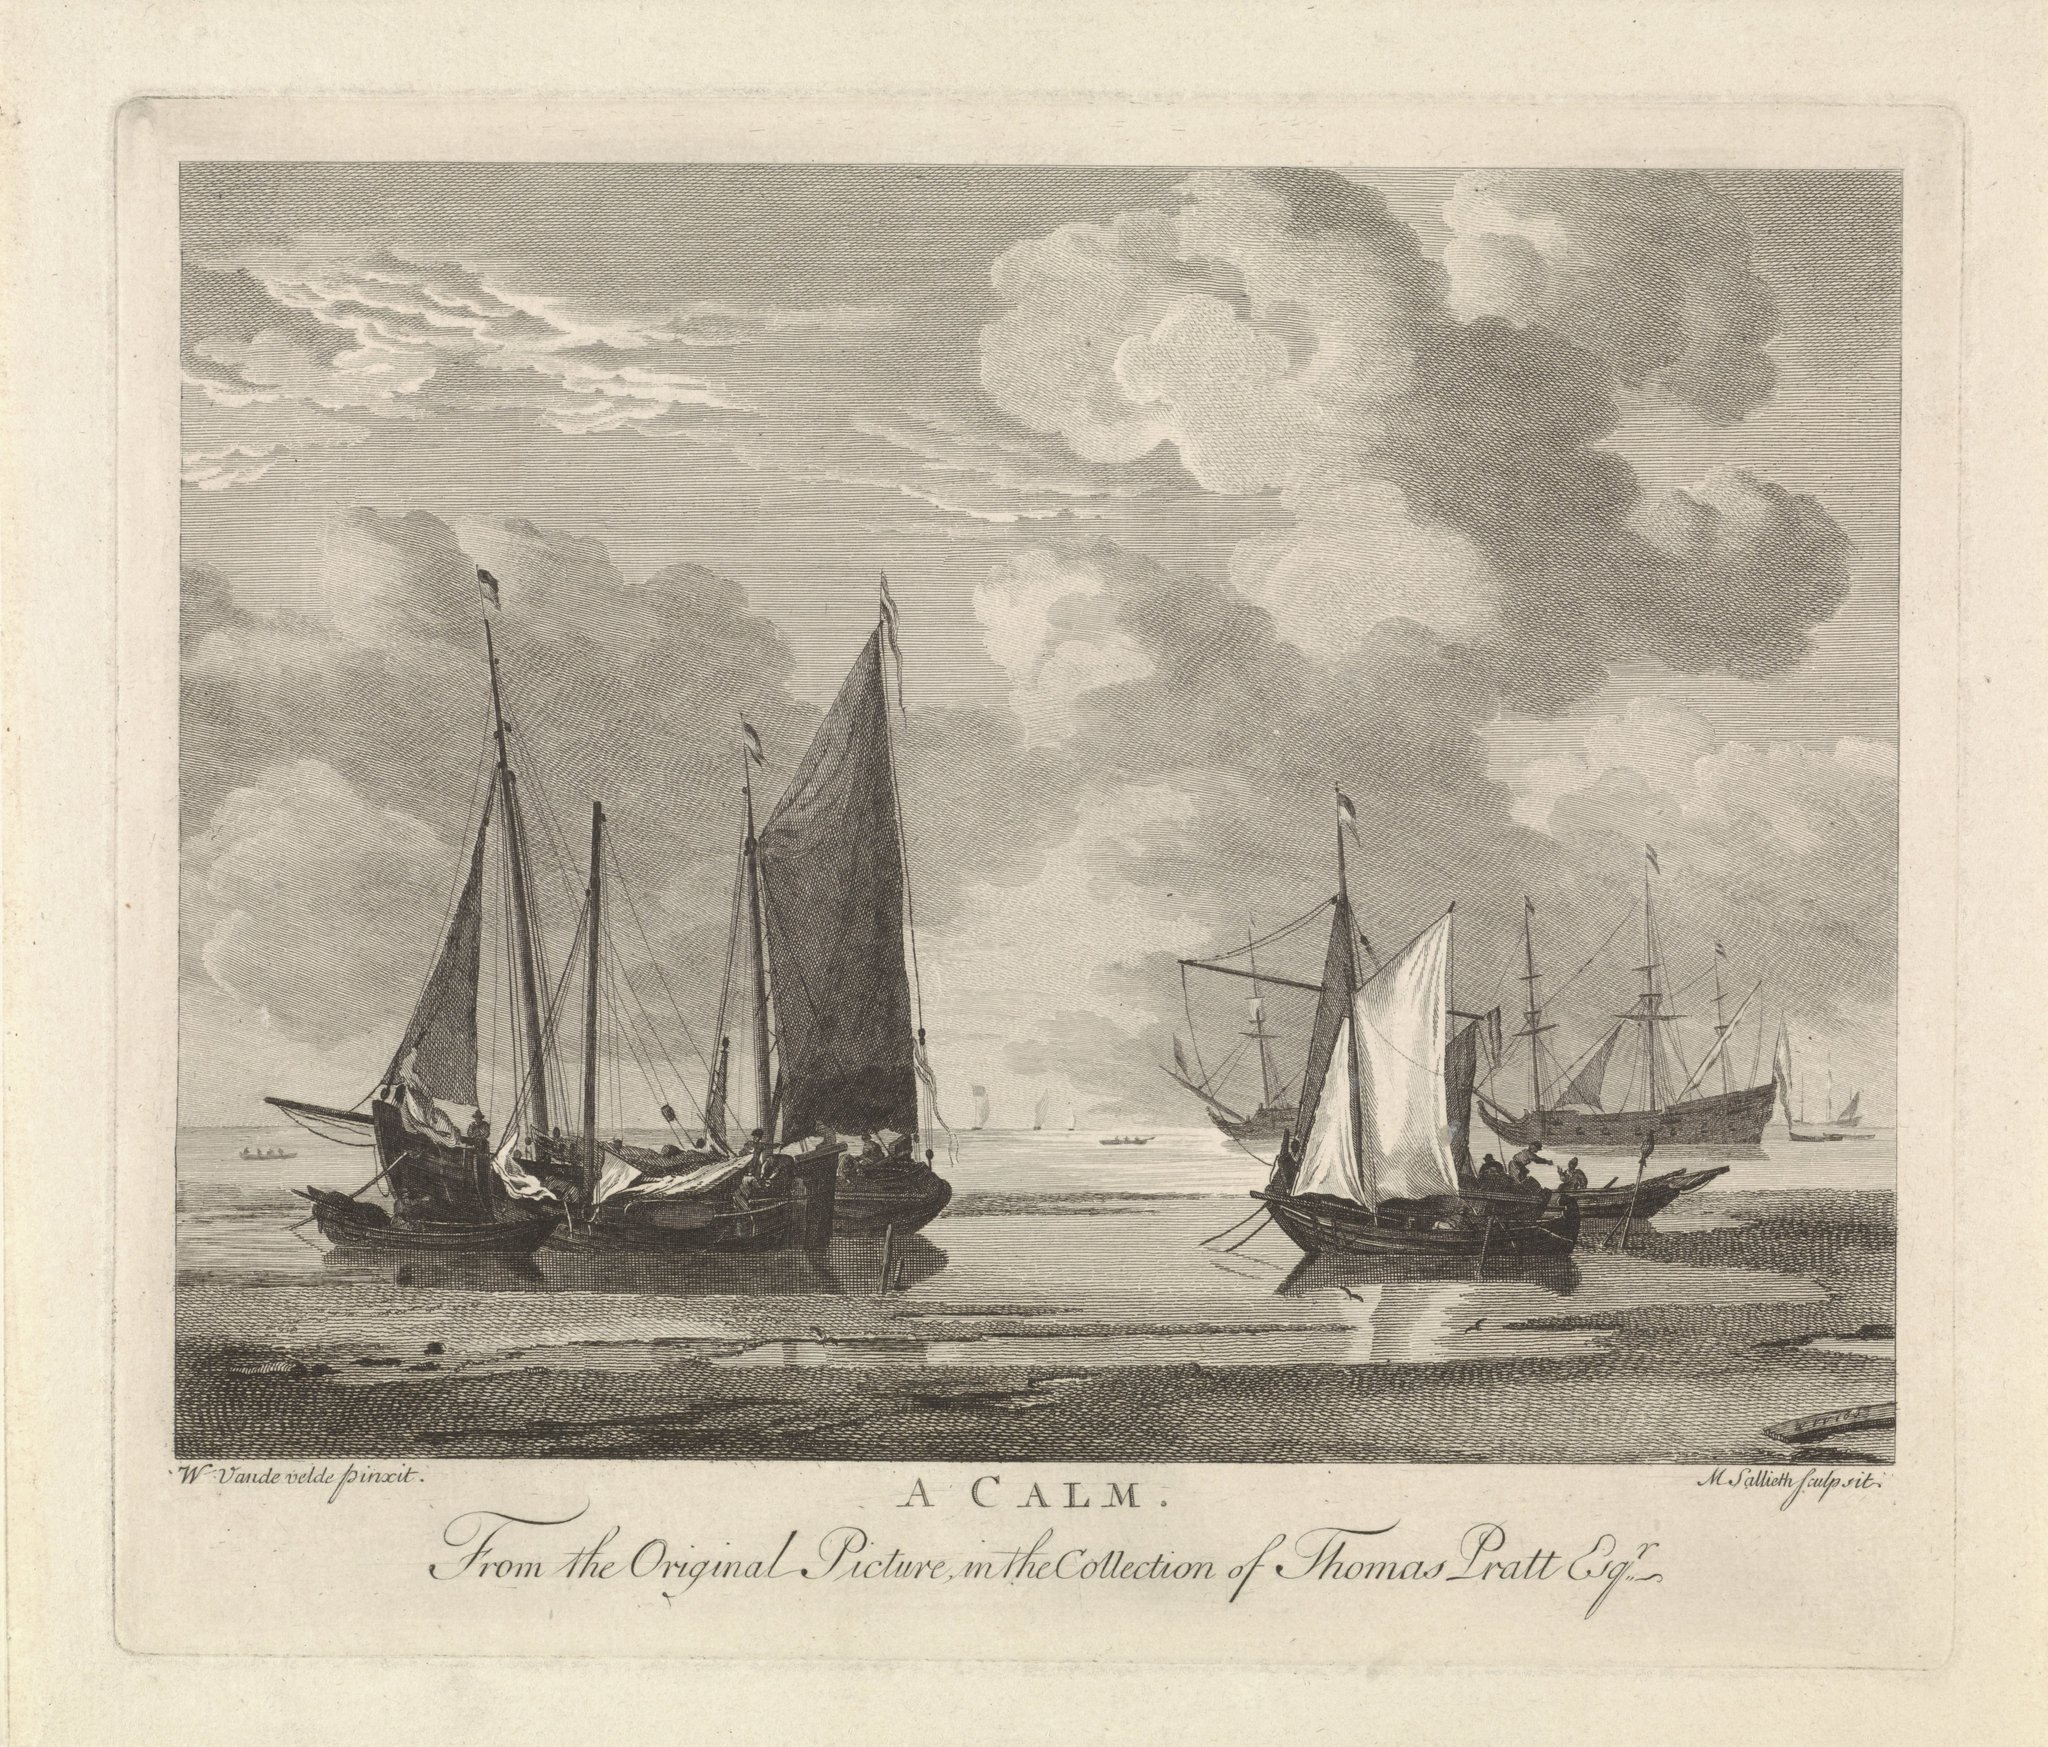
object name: print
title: Rustig water met vissersboten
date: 1764-1791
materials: paper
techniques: etching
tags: absence of wind, calm, sailing-ship, sailing-boat, sea (seascape)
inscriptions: collector's mark: Lugt 2228